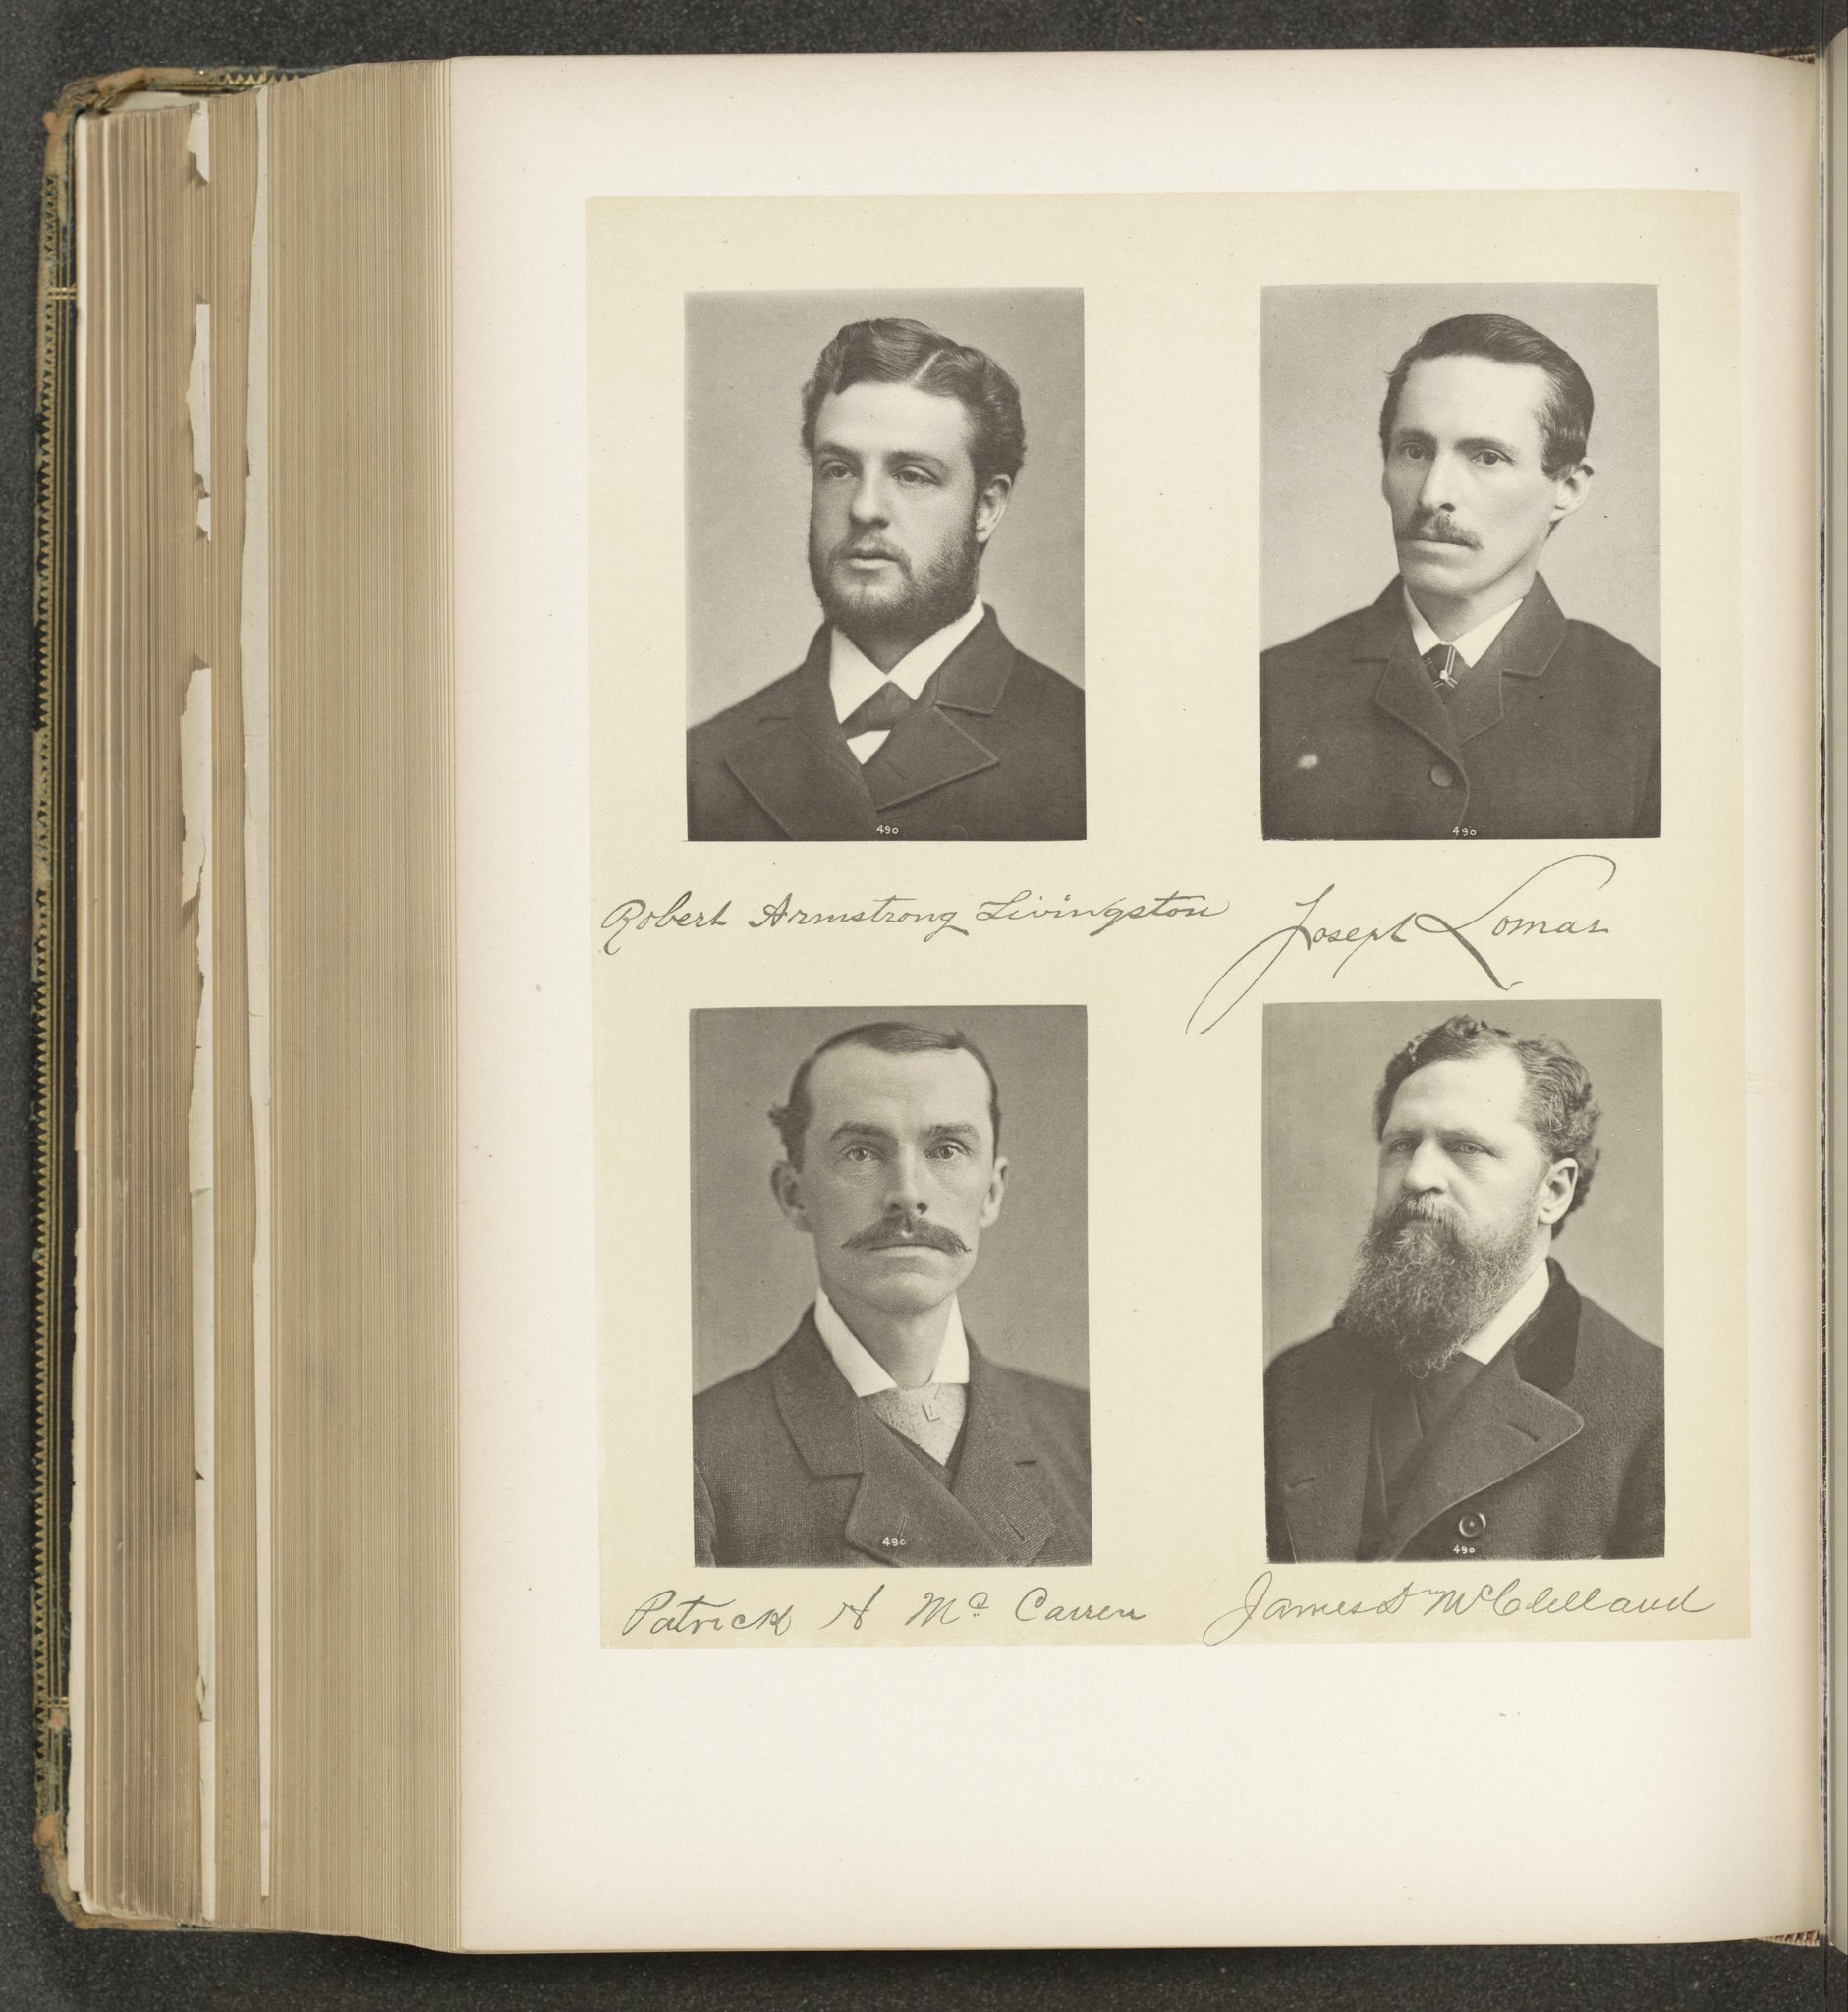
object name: photomechanical print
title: Portretten van vier leden van het Lagerhuis van de staat New York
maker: Anonymous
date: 1872-1882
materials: paper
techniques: photograph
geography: united states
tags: historical persons (portraits and scenes from the life) (+ head (and shoulders) (portrait))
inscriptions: annotation, number: ‘490’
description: Linksboven Robert Armstrong Livingston, rechtsboven Joseph Lomas, linksonder Patrick H. McCarren, rechtsonder James D. McLelland.